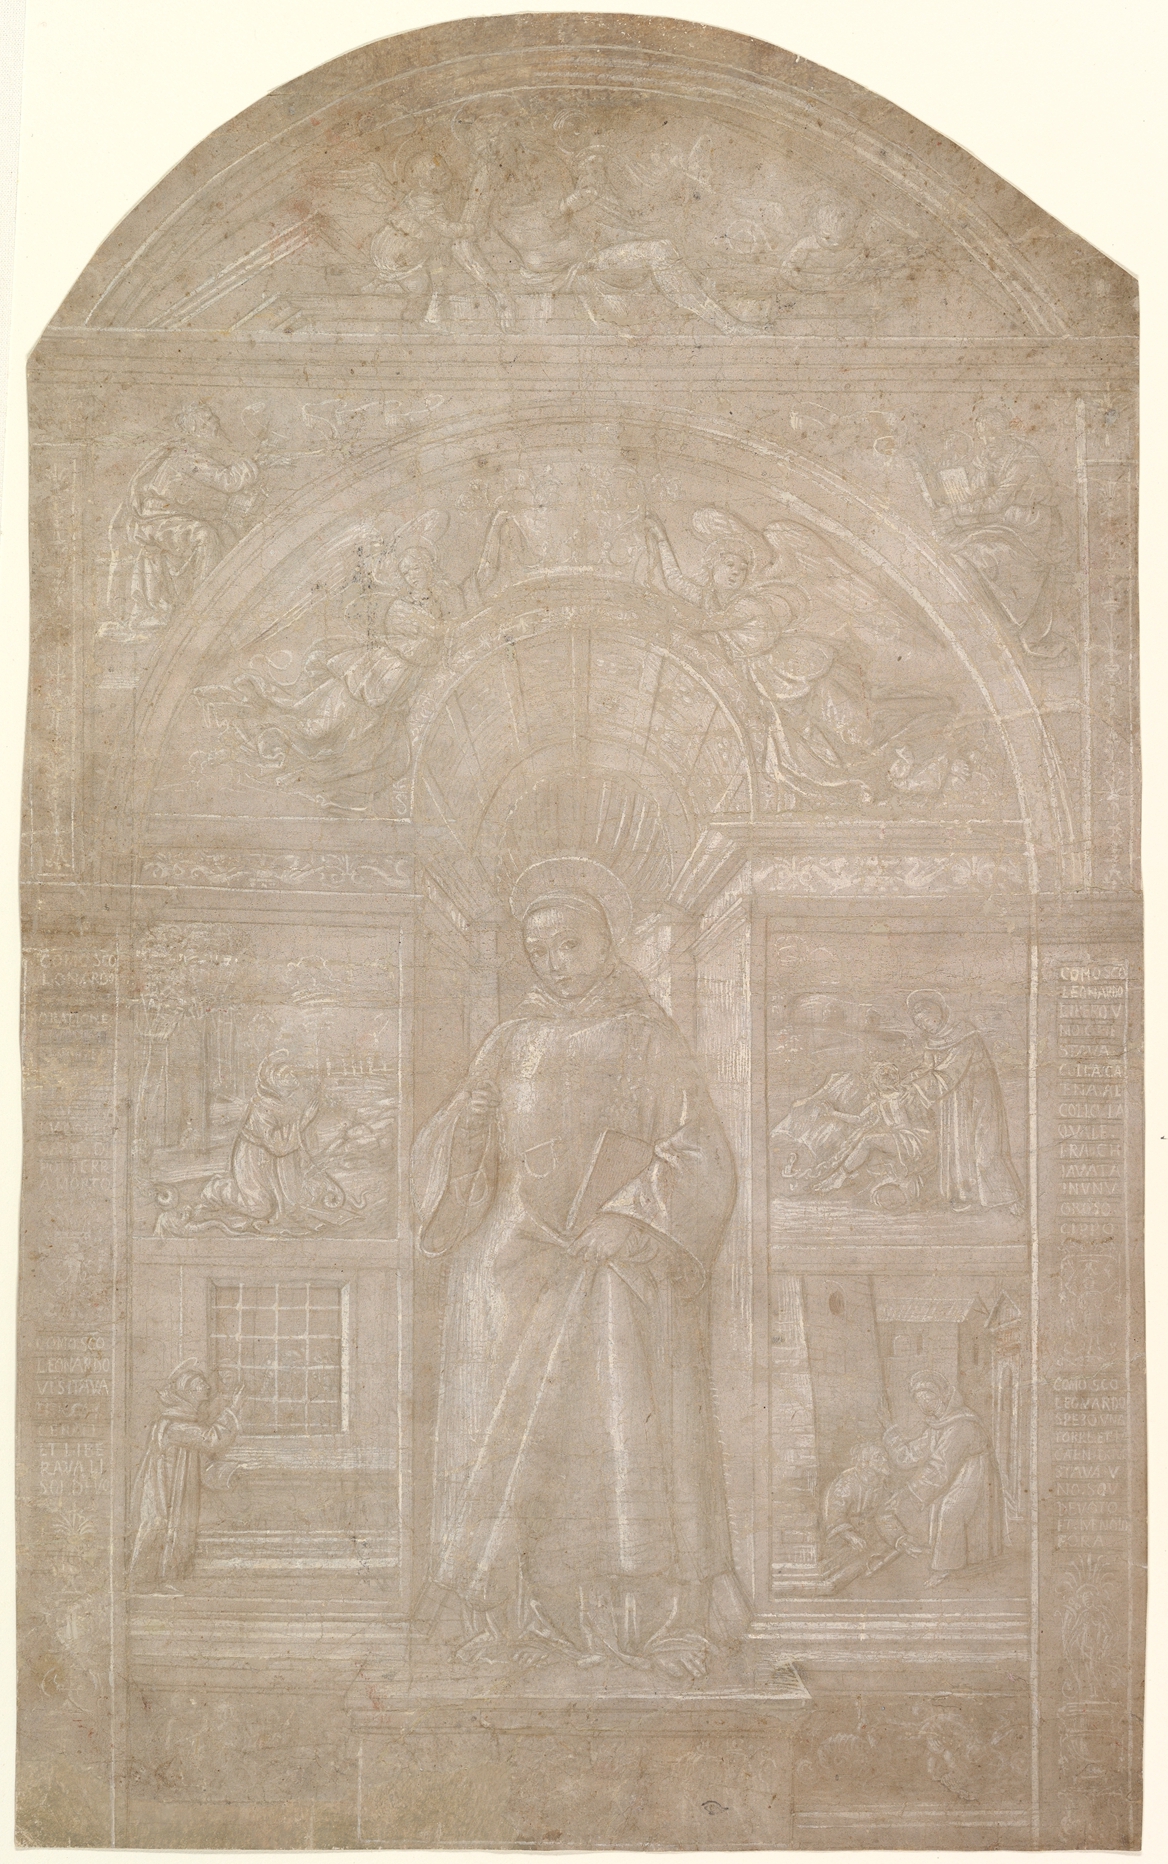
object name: drawing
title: Saint Leonard and Four Episodes from His Life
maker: francesco di paolo da montereale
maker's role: artist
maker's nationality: italian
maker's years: 1470-1549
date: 1500-1510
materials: gouache, paper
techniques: brush, highlighting, incising, wash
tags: human figures,angels,saint leonard